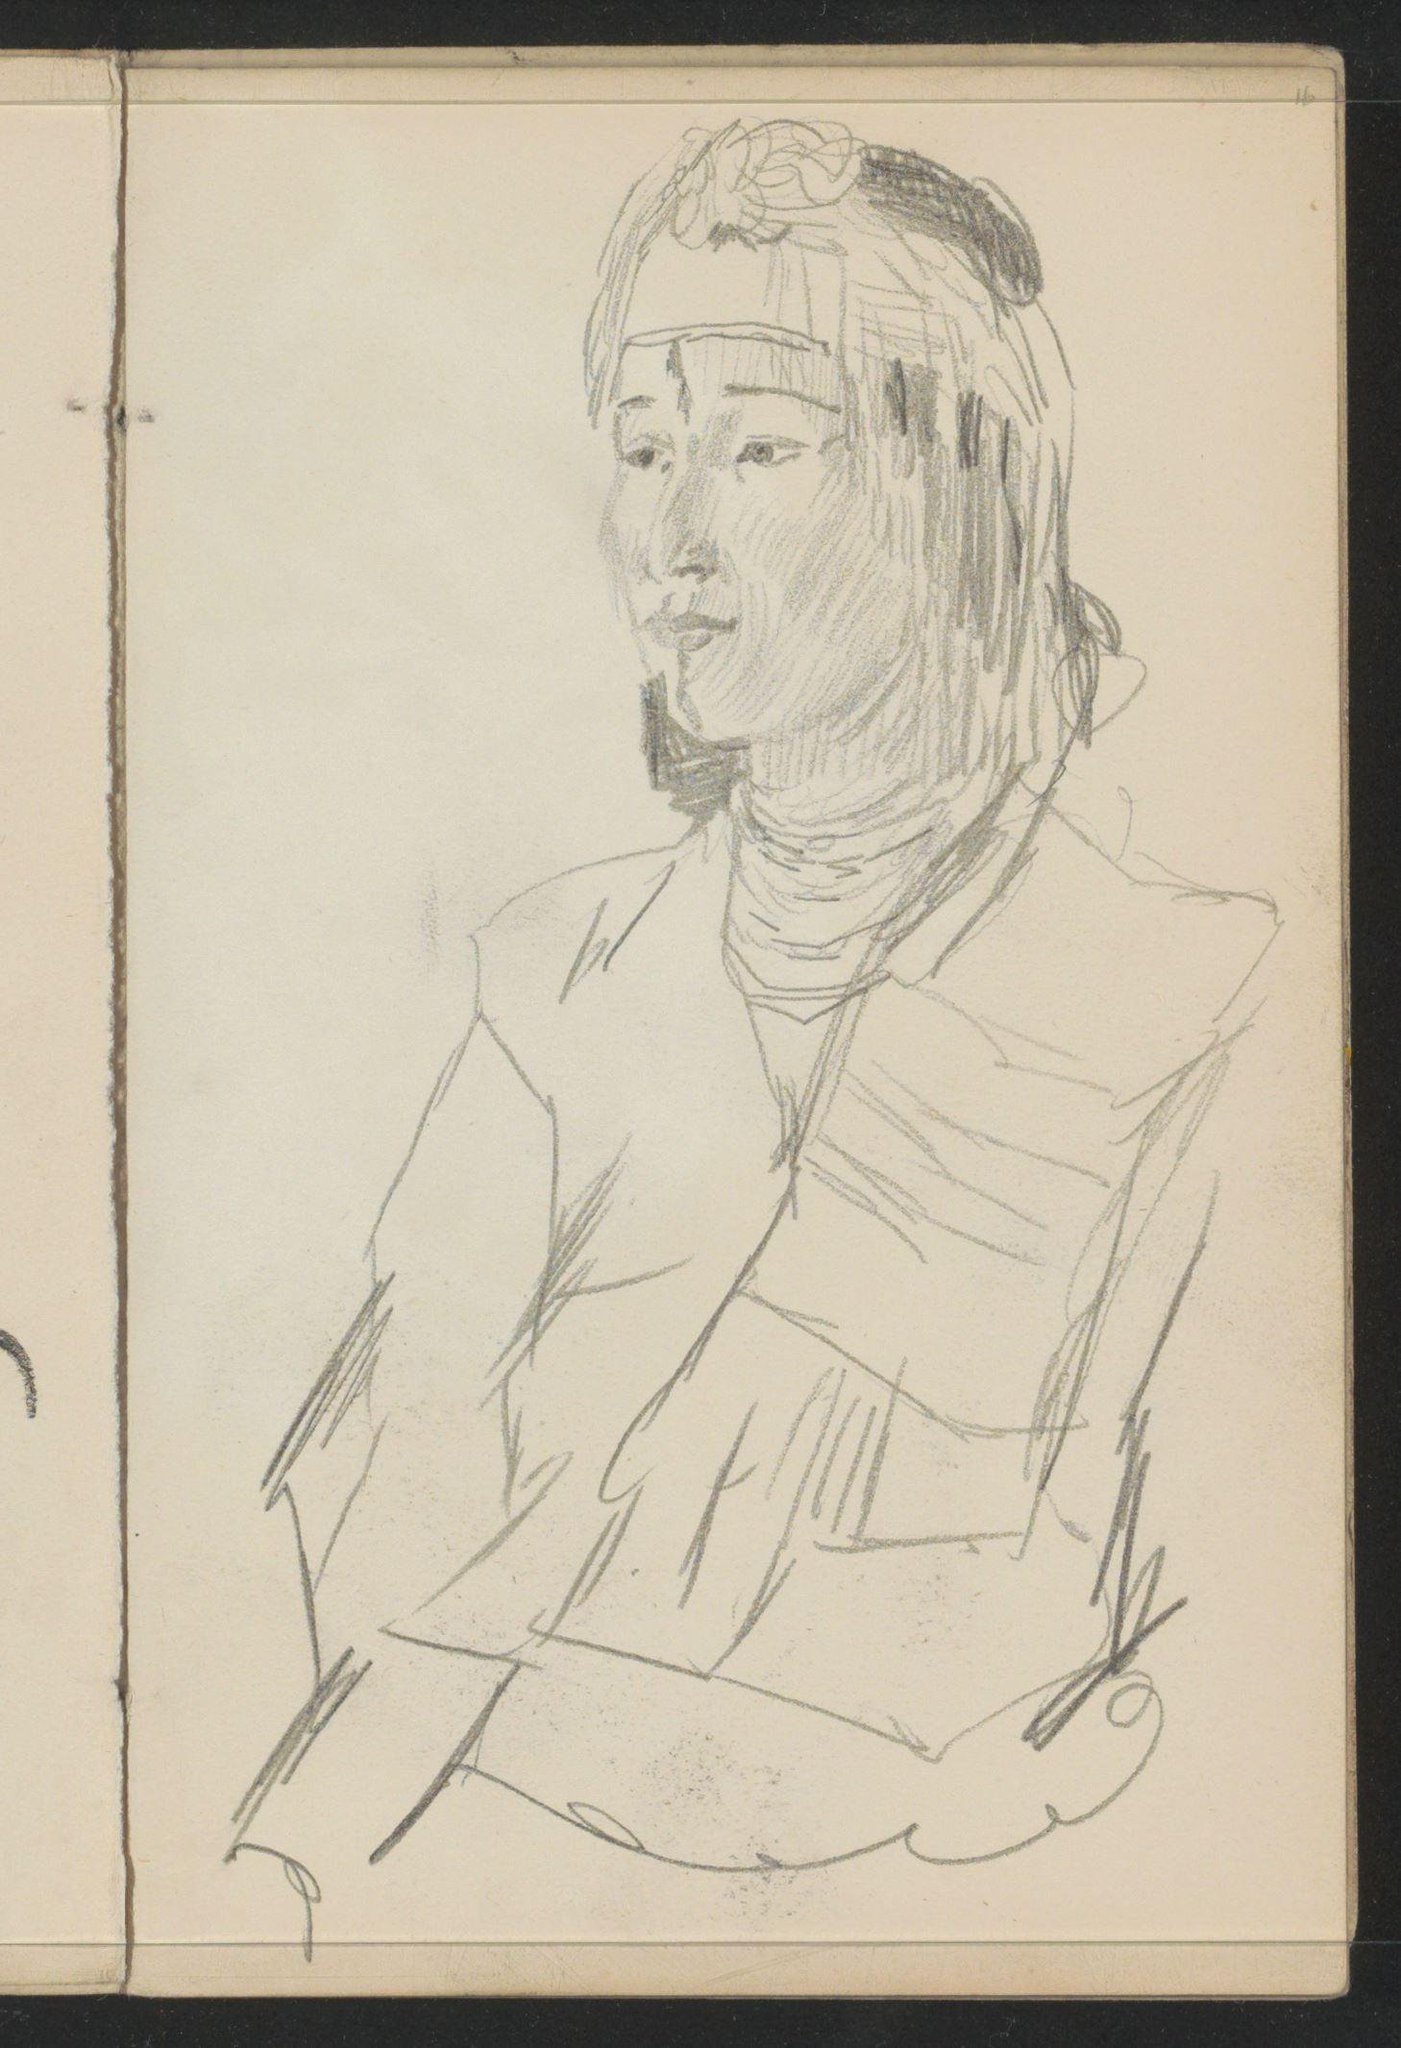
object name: sketchbook leaf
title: Vrouw, mogelijk oosters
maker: isaac israels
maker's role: draughtsman, painter, print maker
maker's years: 1865-1934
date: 1887-1934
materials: paper, pencil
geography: paris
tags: adult woman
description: Pagina 16 uit schetsboek XXXIX met 51 pagina's.